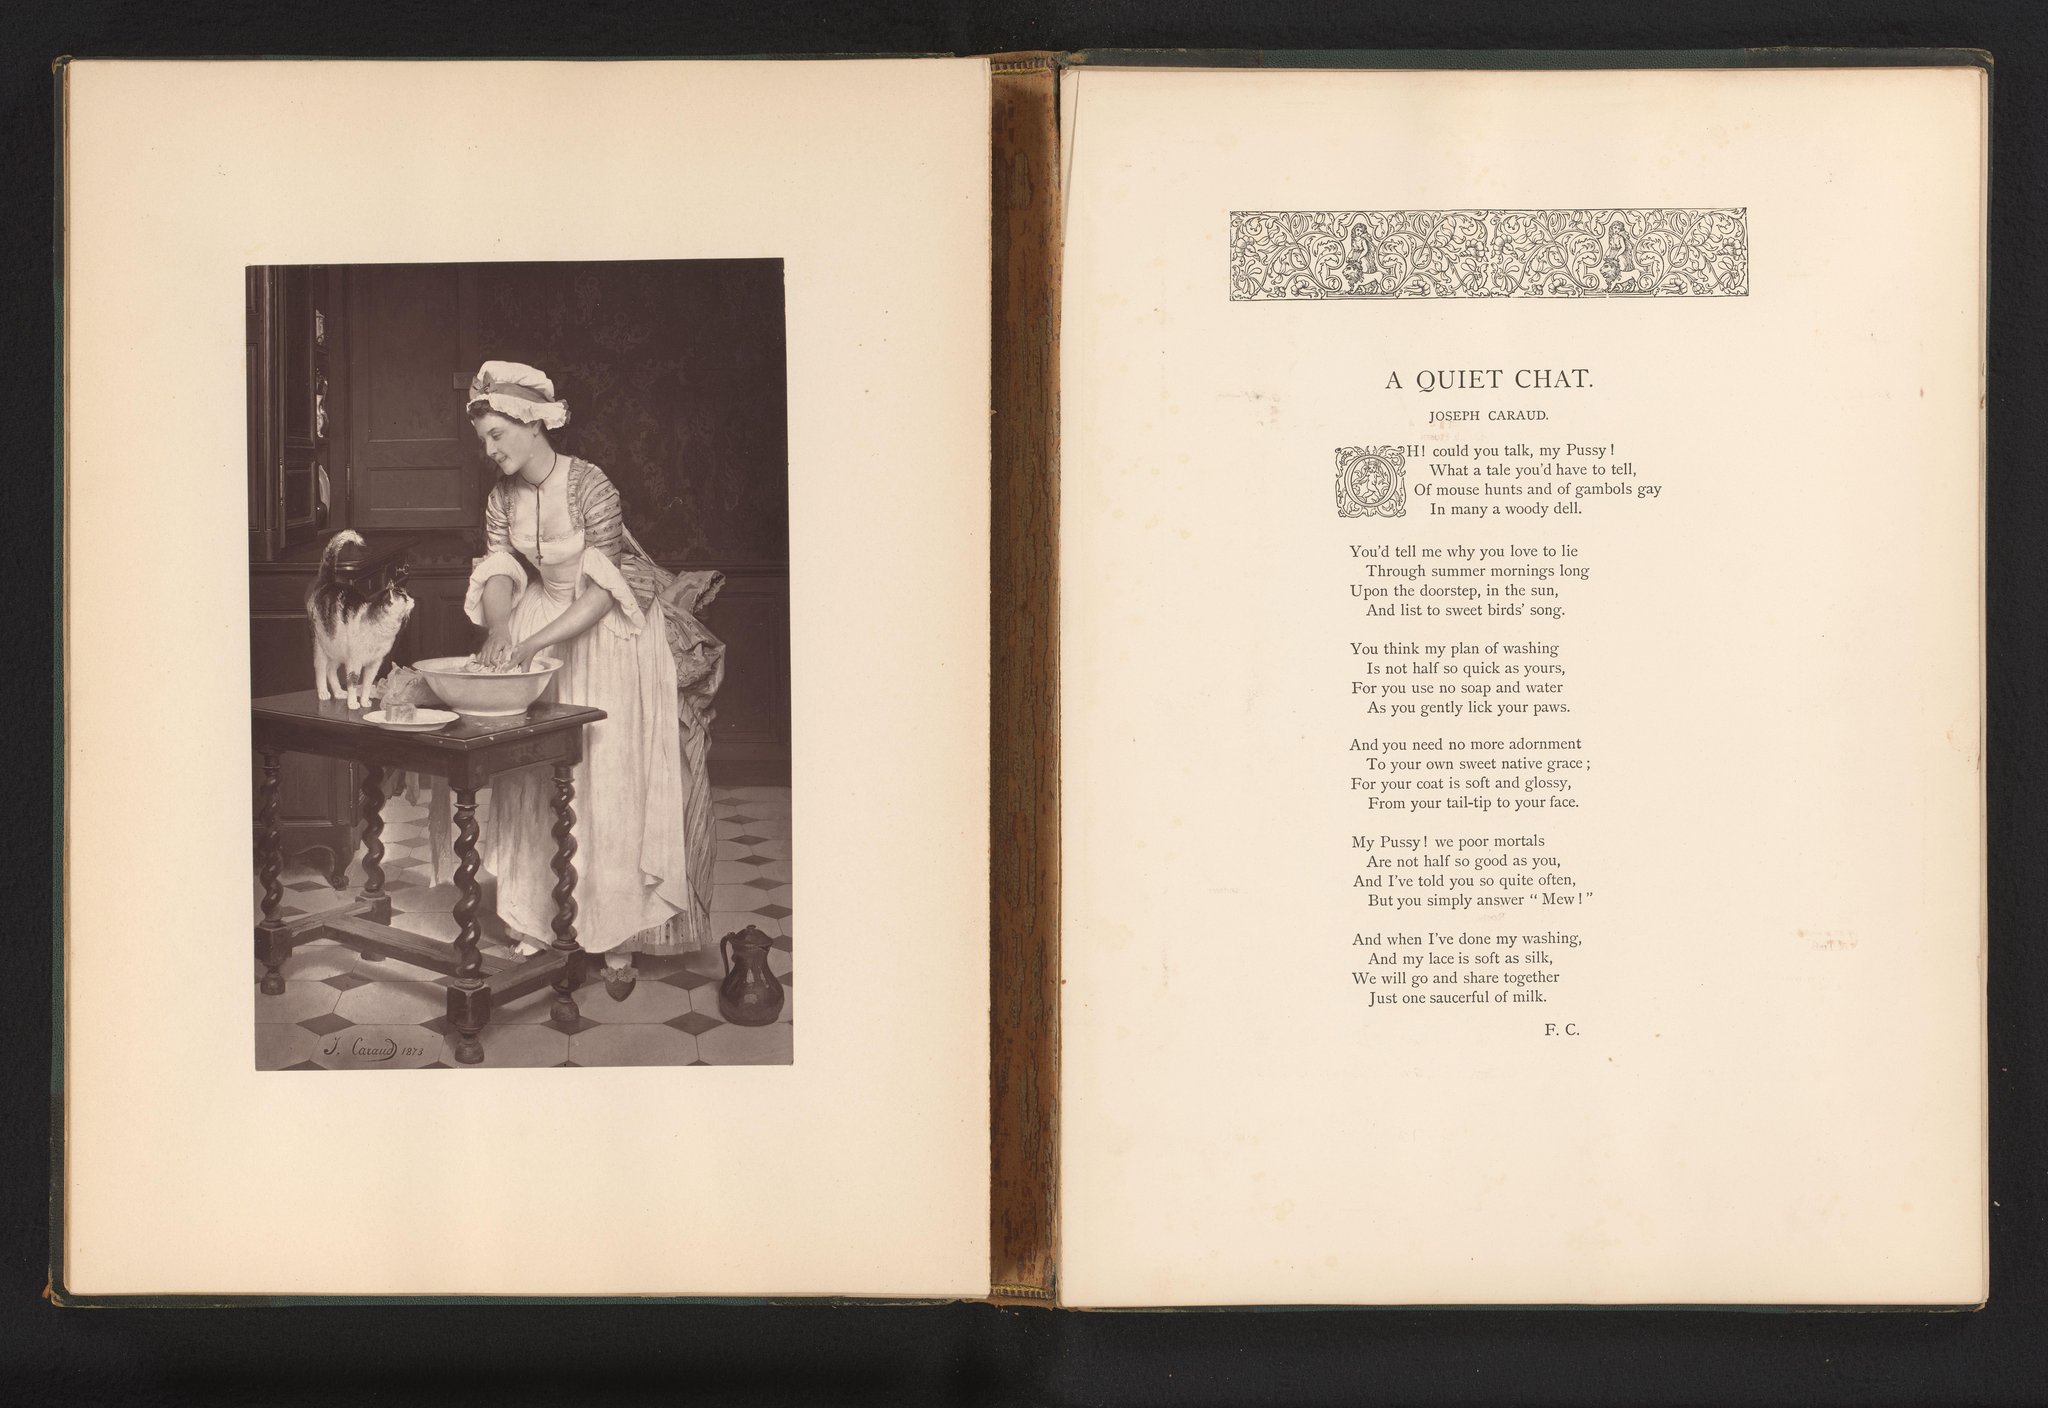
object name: photomechanical print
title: Reproductie van een schilderij van een vrouw die kleding met de hand wast door Joseph Caraud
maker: Anonymous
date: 1874-1879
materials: paper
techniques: woodburytype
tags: cat, wash house, home laundry, laundry room